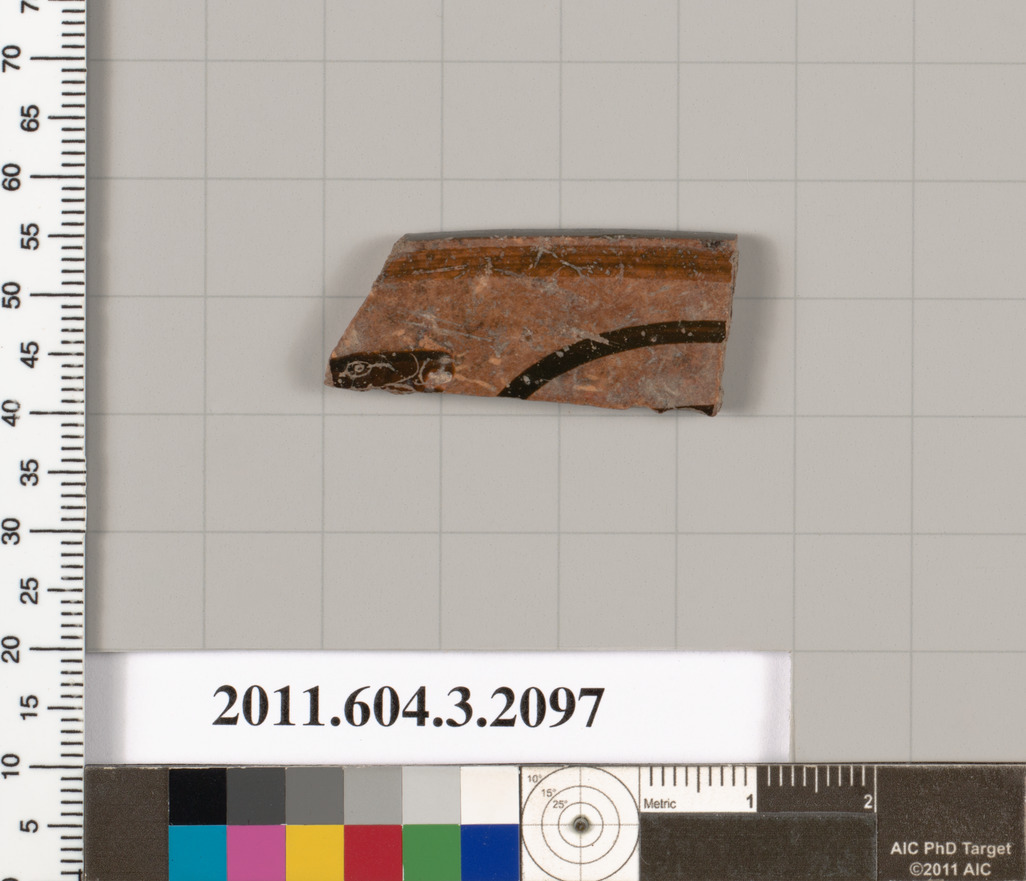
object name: kylix fragment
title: Terracotta rim fragment of a kylix (drinking cup)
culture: greek, attic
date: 525-501 BCE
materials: terracotta